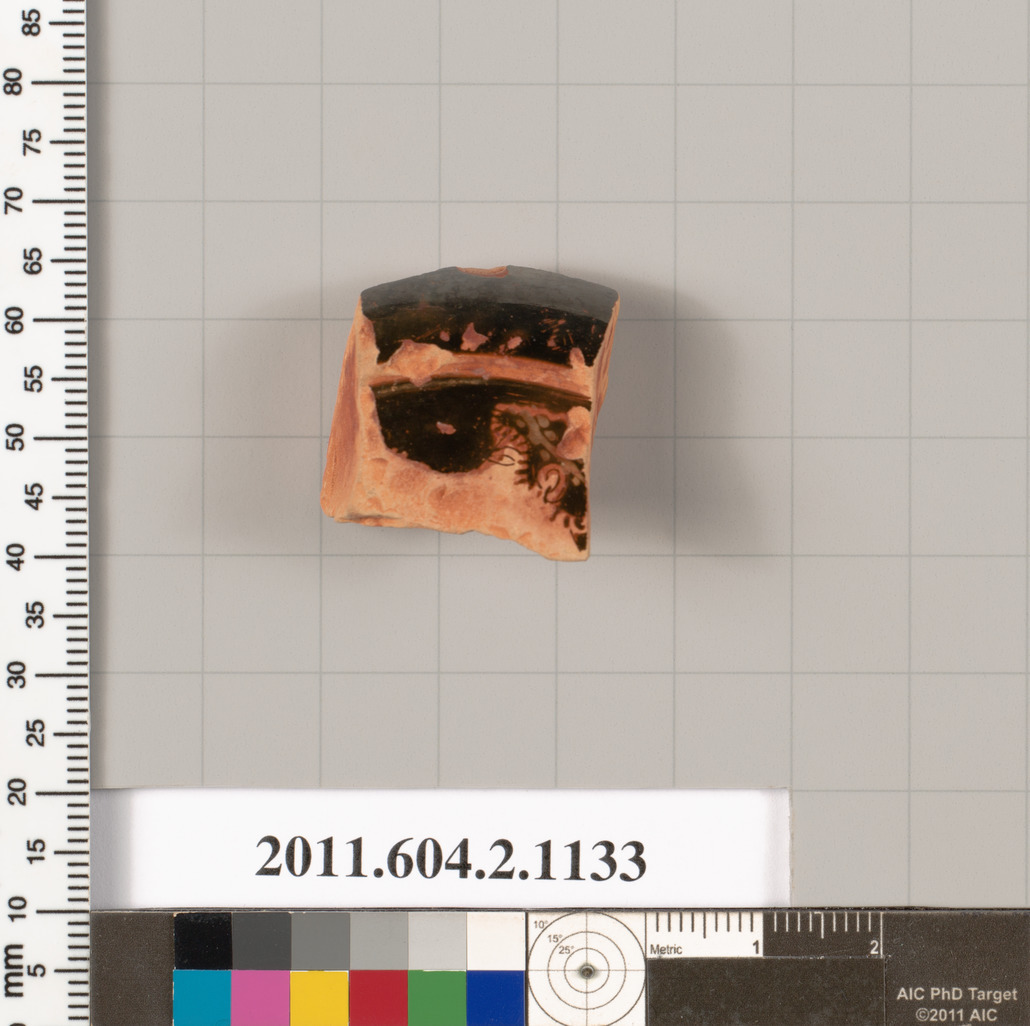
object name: standlet fragment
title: Terracotta fragment of a standlet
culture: greek, attic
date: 520-500 BCE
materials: terracotta